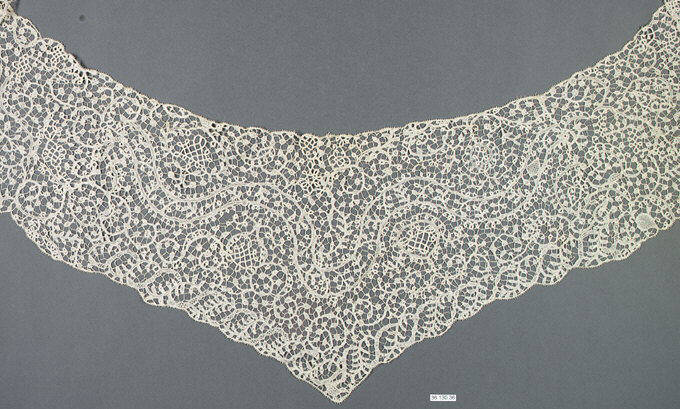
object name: garniture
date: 1601-1700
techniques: lace